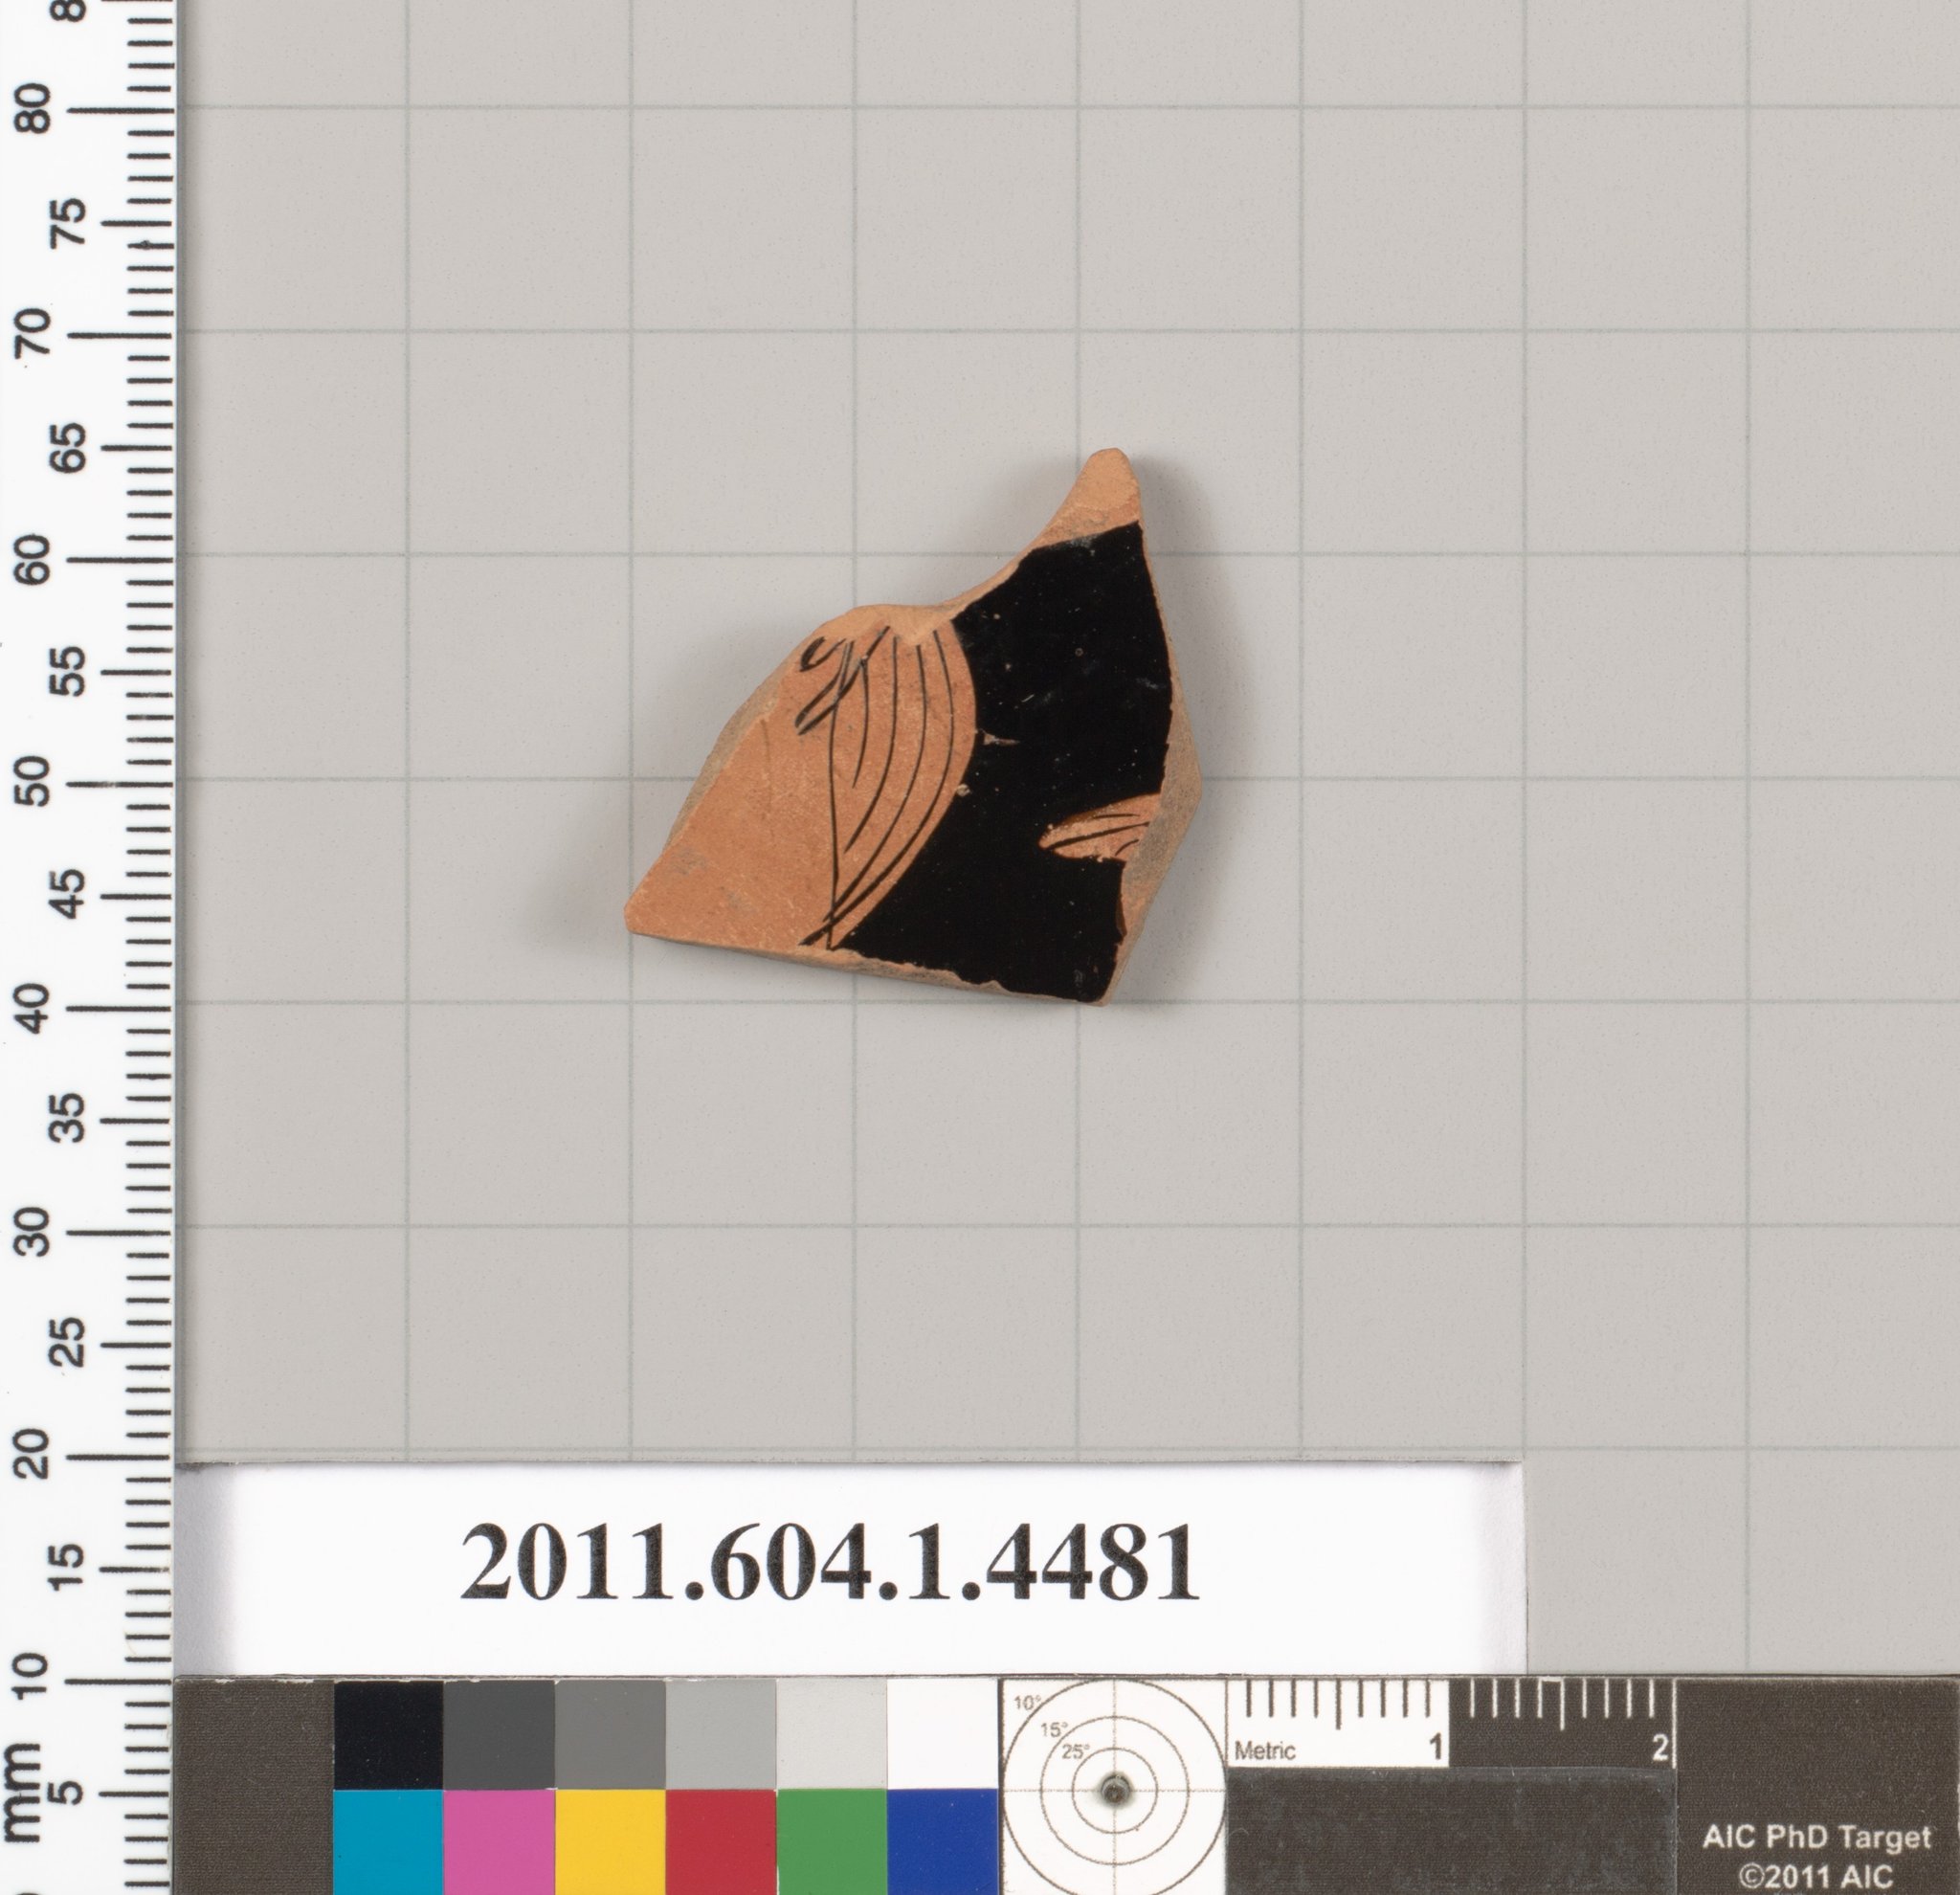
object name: kylix fragment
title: Terracotta fragment of a kylix (drinking cup)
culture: greek, attic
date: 475-451 BCE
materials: terracotta